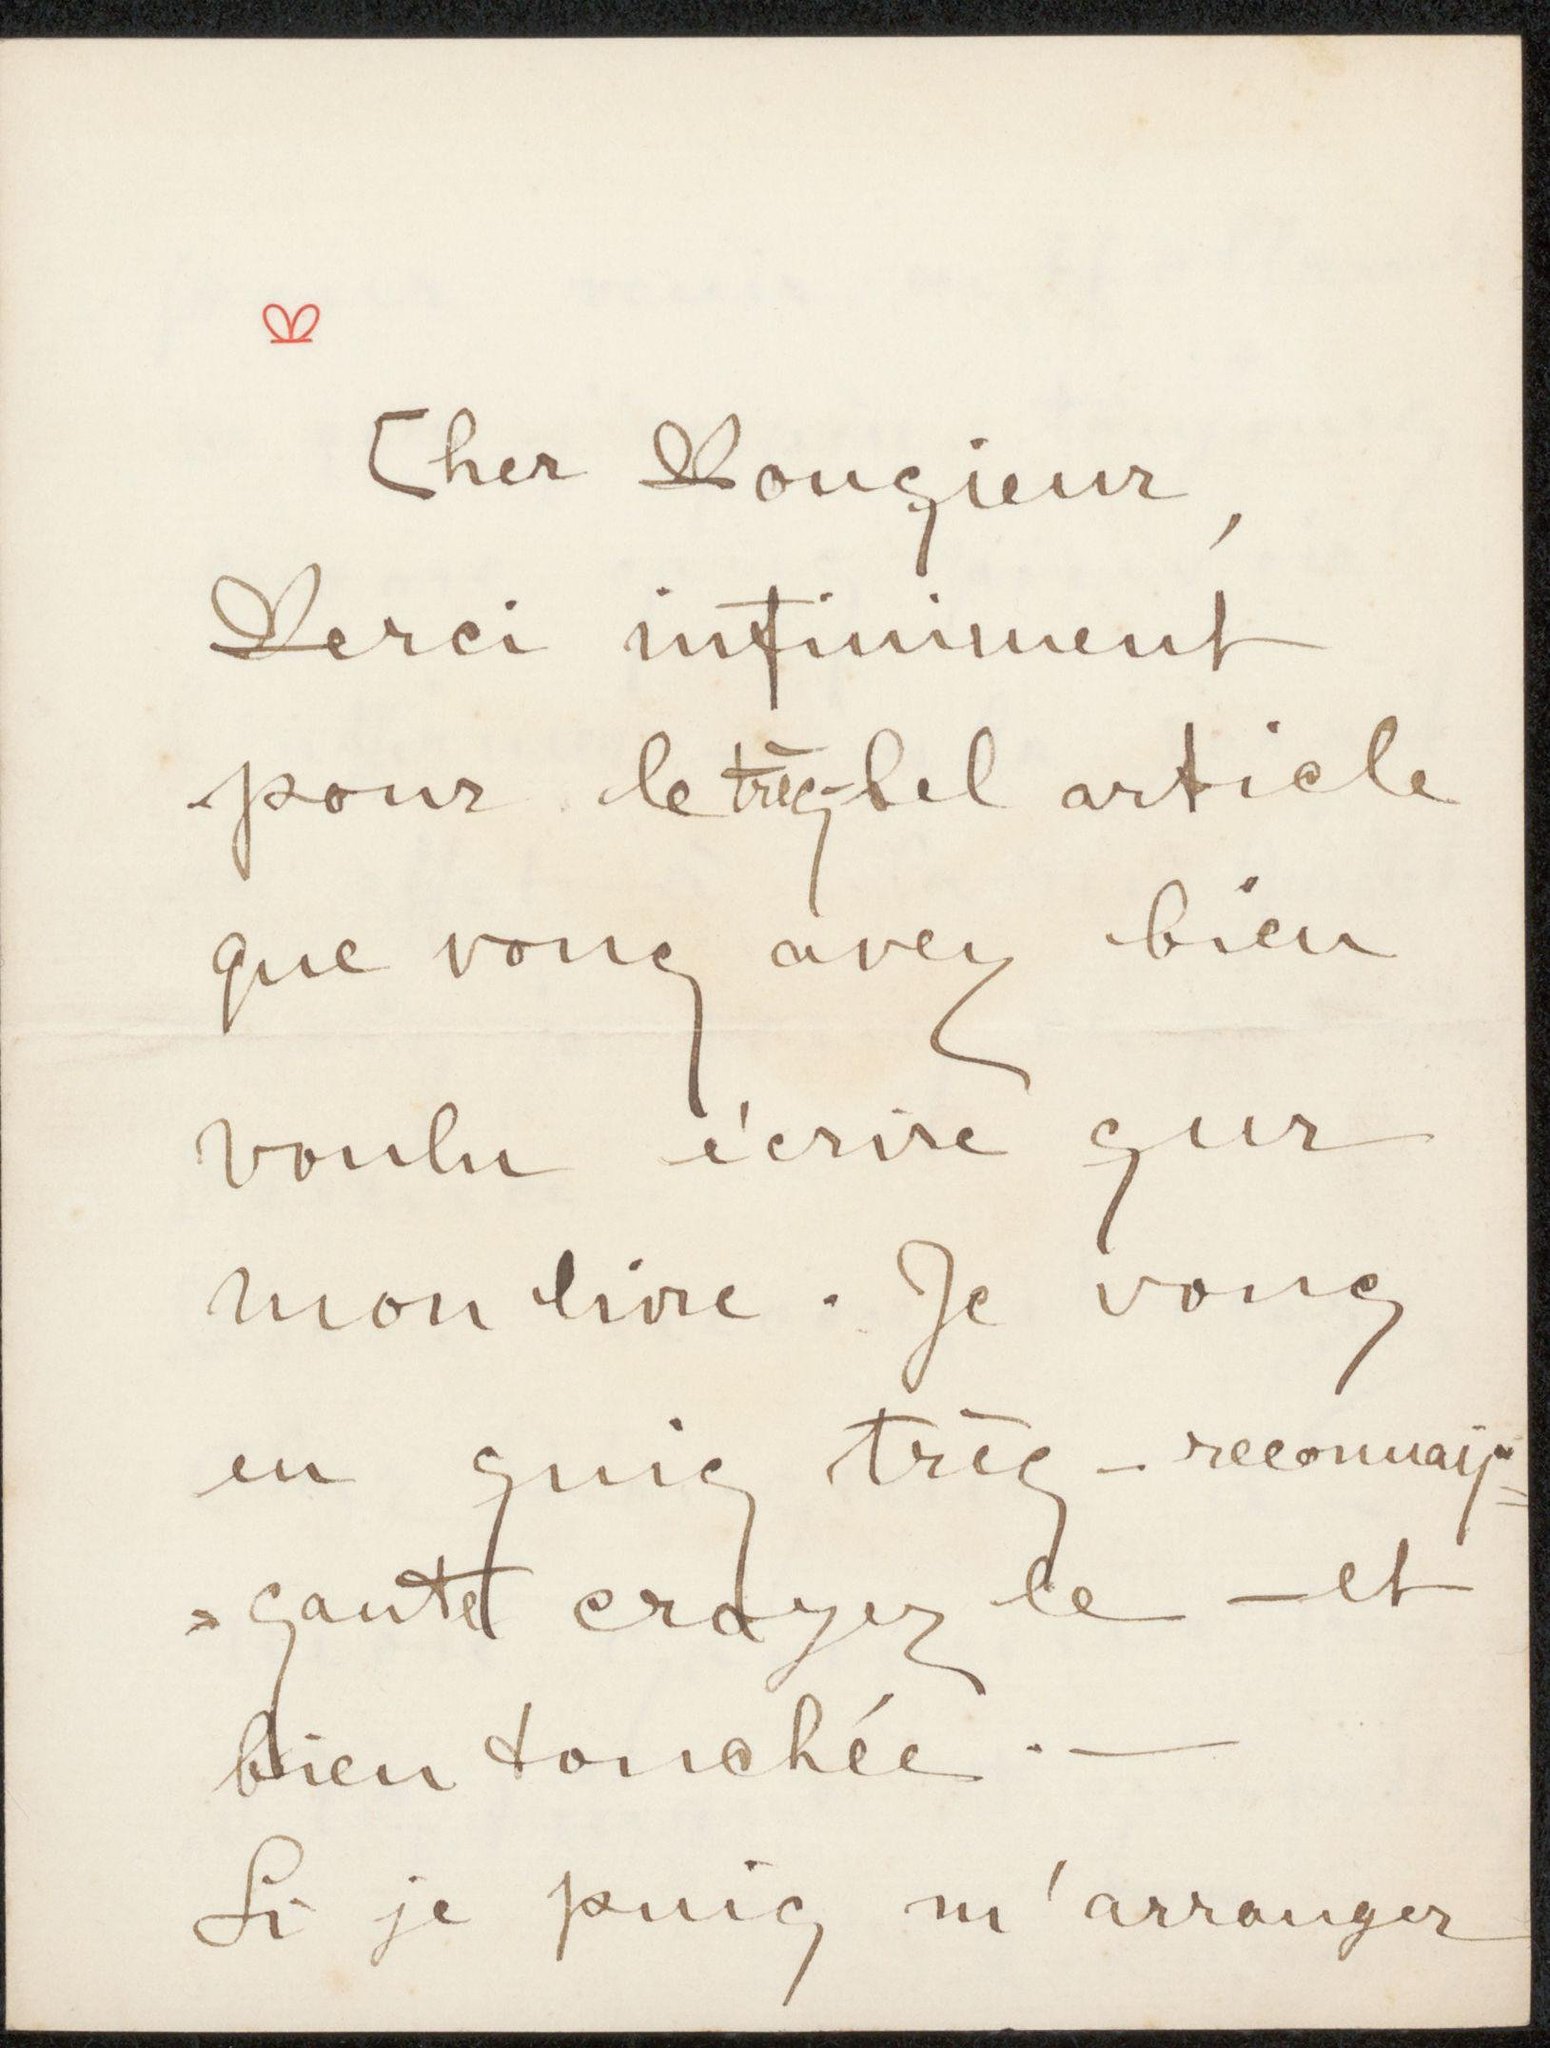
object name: letter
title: Brief aan Philip Zilcken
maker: baronne madeleine deslandes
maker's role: schrijver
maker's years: 1866-1929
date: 1876-1929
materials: ink, paper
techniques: writing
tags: the hague, painter, draughtsman, philip zilcken, literature ~ arts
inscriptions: collector's mark: ‘RPK’